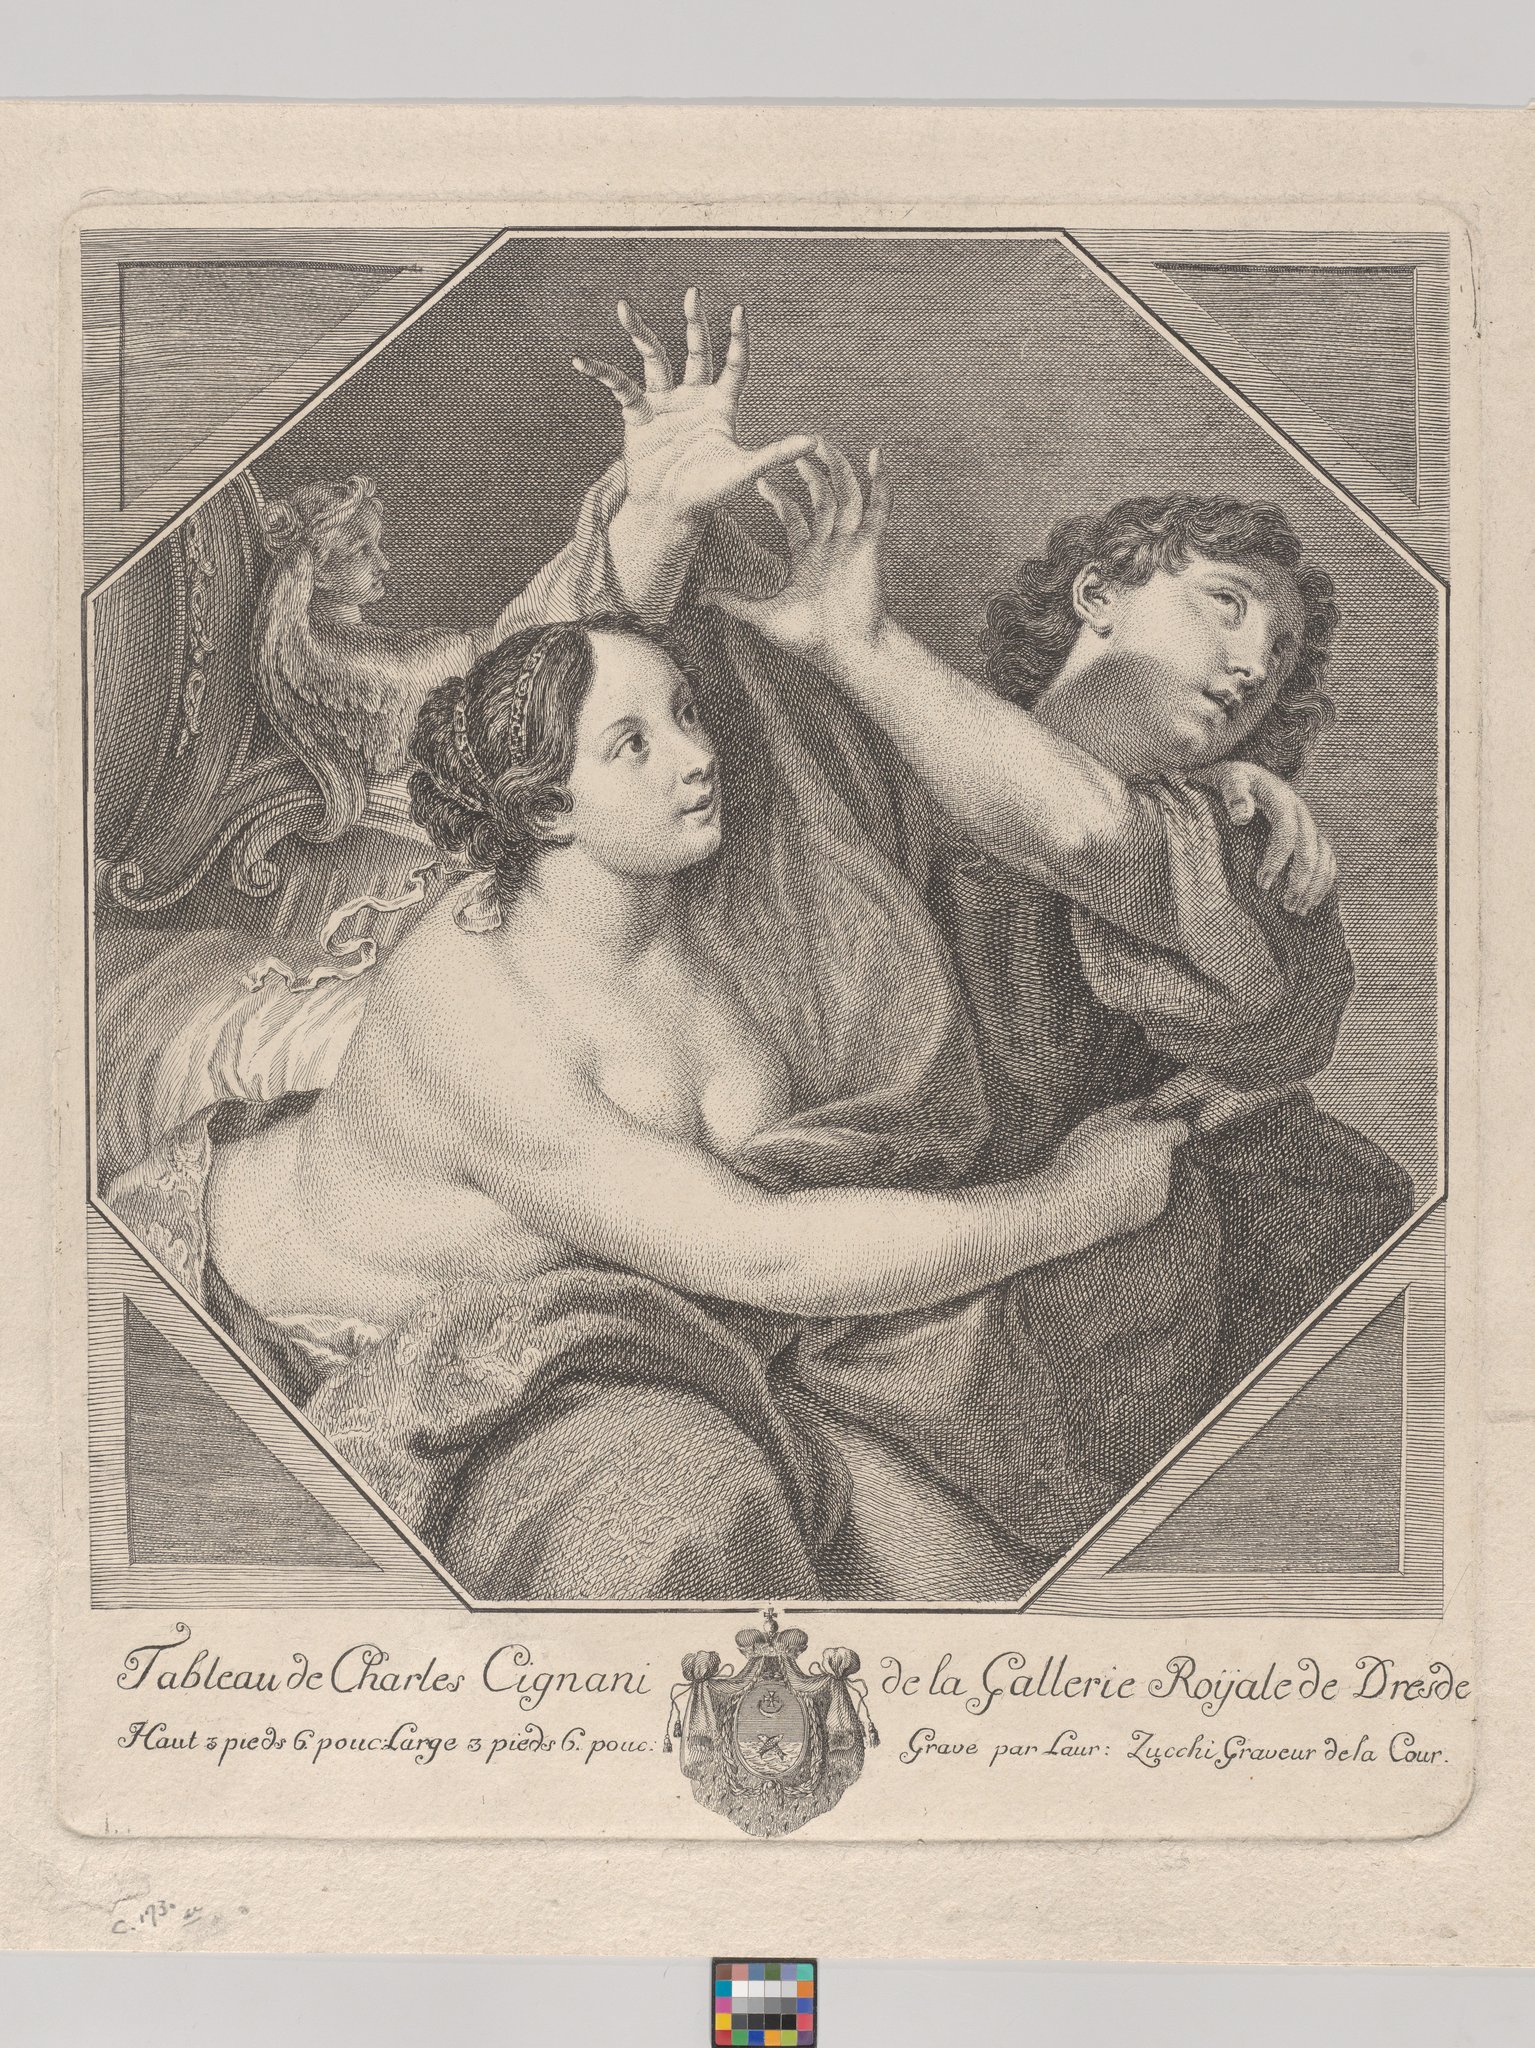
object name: print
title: Joseph and Potiphar's Wife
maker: lorenzo zucchi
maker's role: artist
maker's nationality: italian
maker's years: 1704-1779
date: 1725-1779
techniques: etching